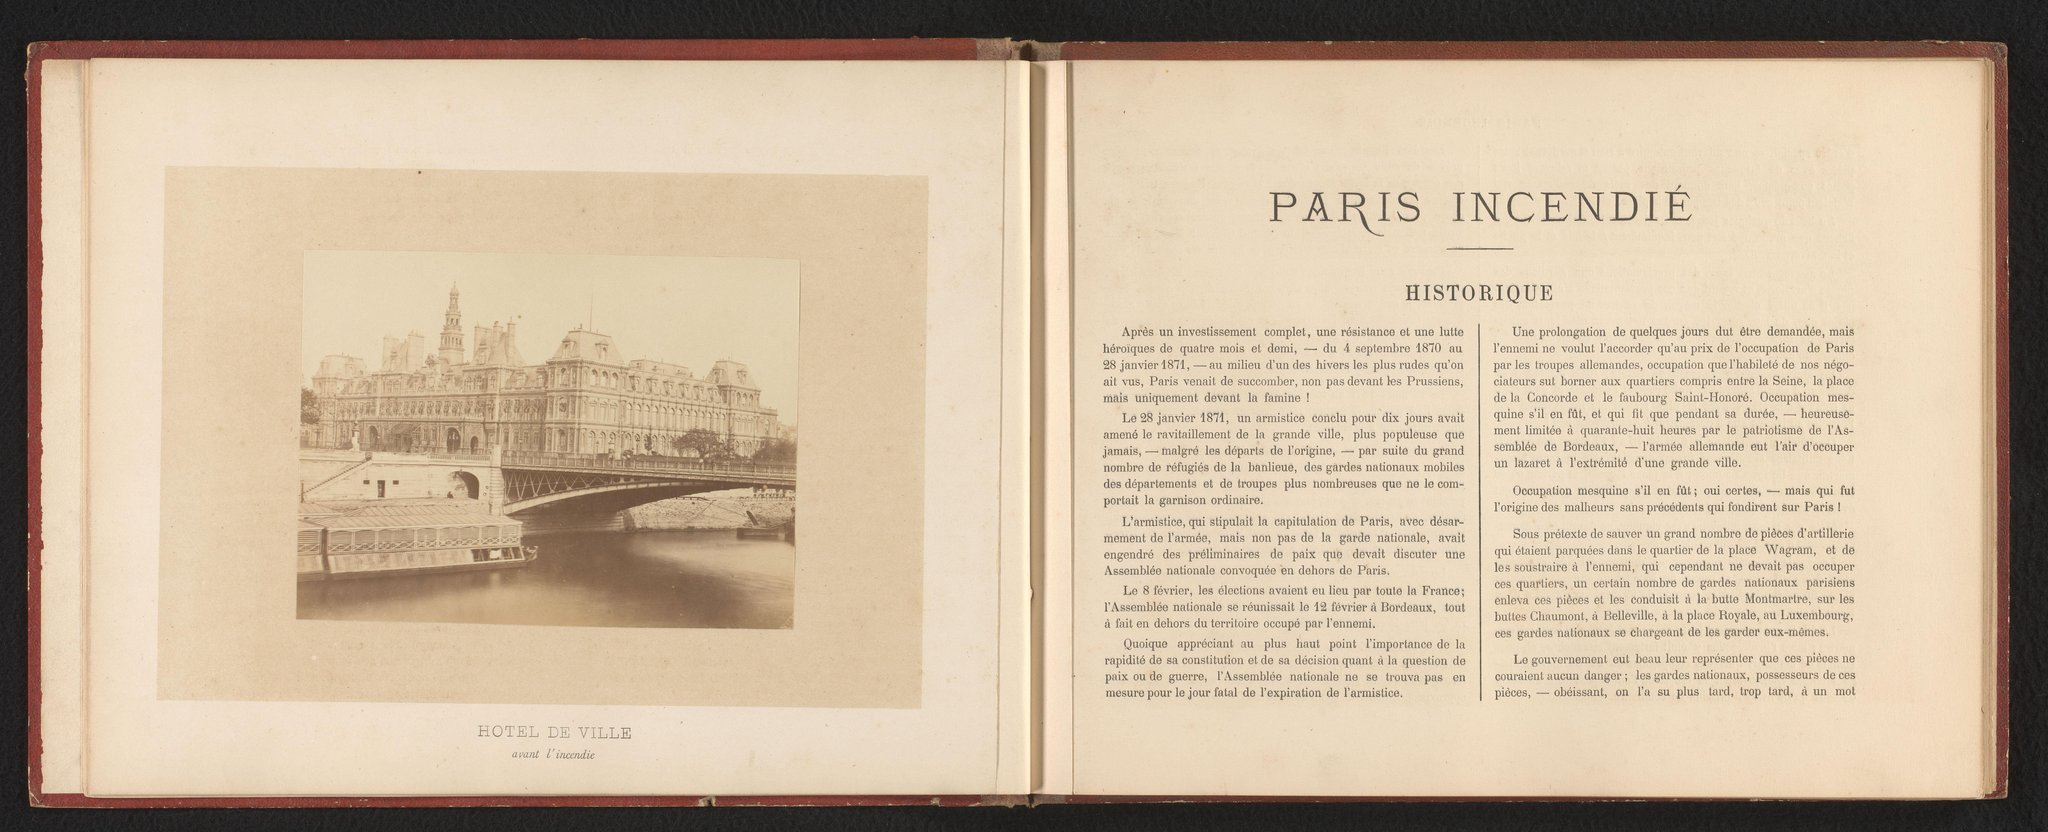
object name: page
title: Hotel de Ville, avant l'incendie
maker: Anonymous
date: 1866-1871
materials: paper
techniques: albumen print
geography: paris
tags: townhall